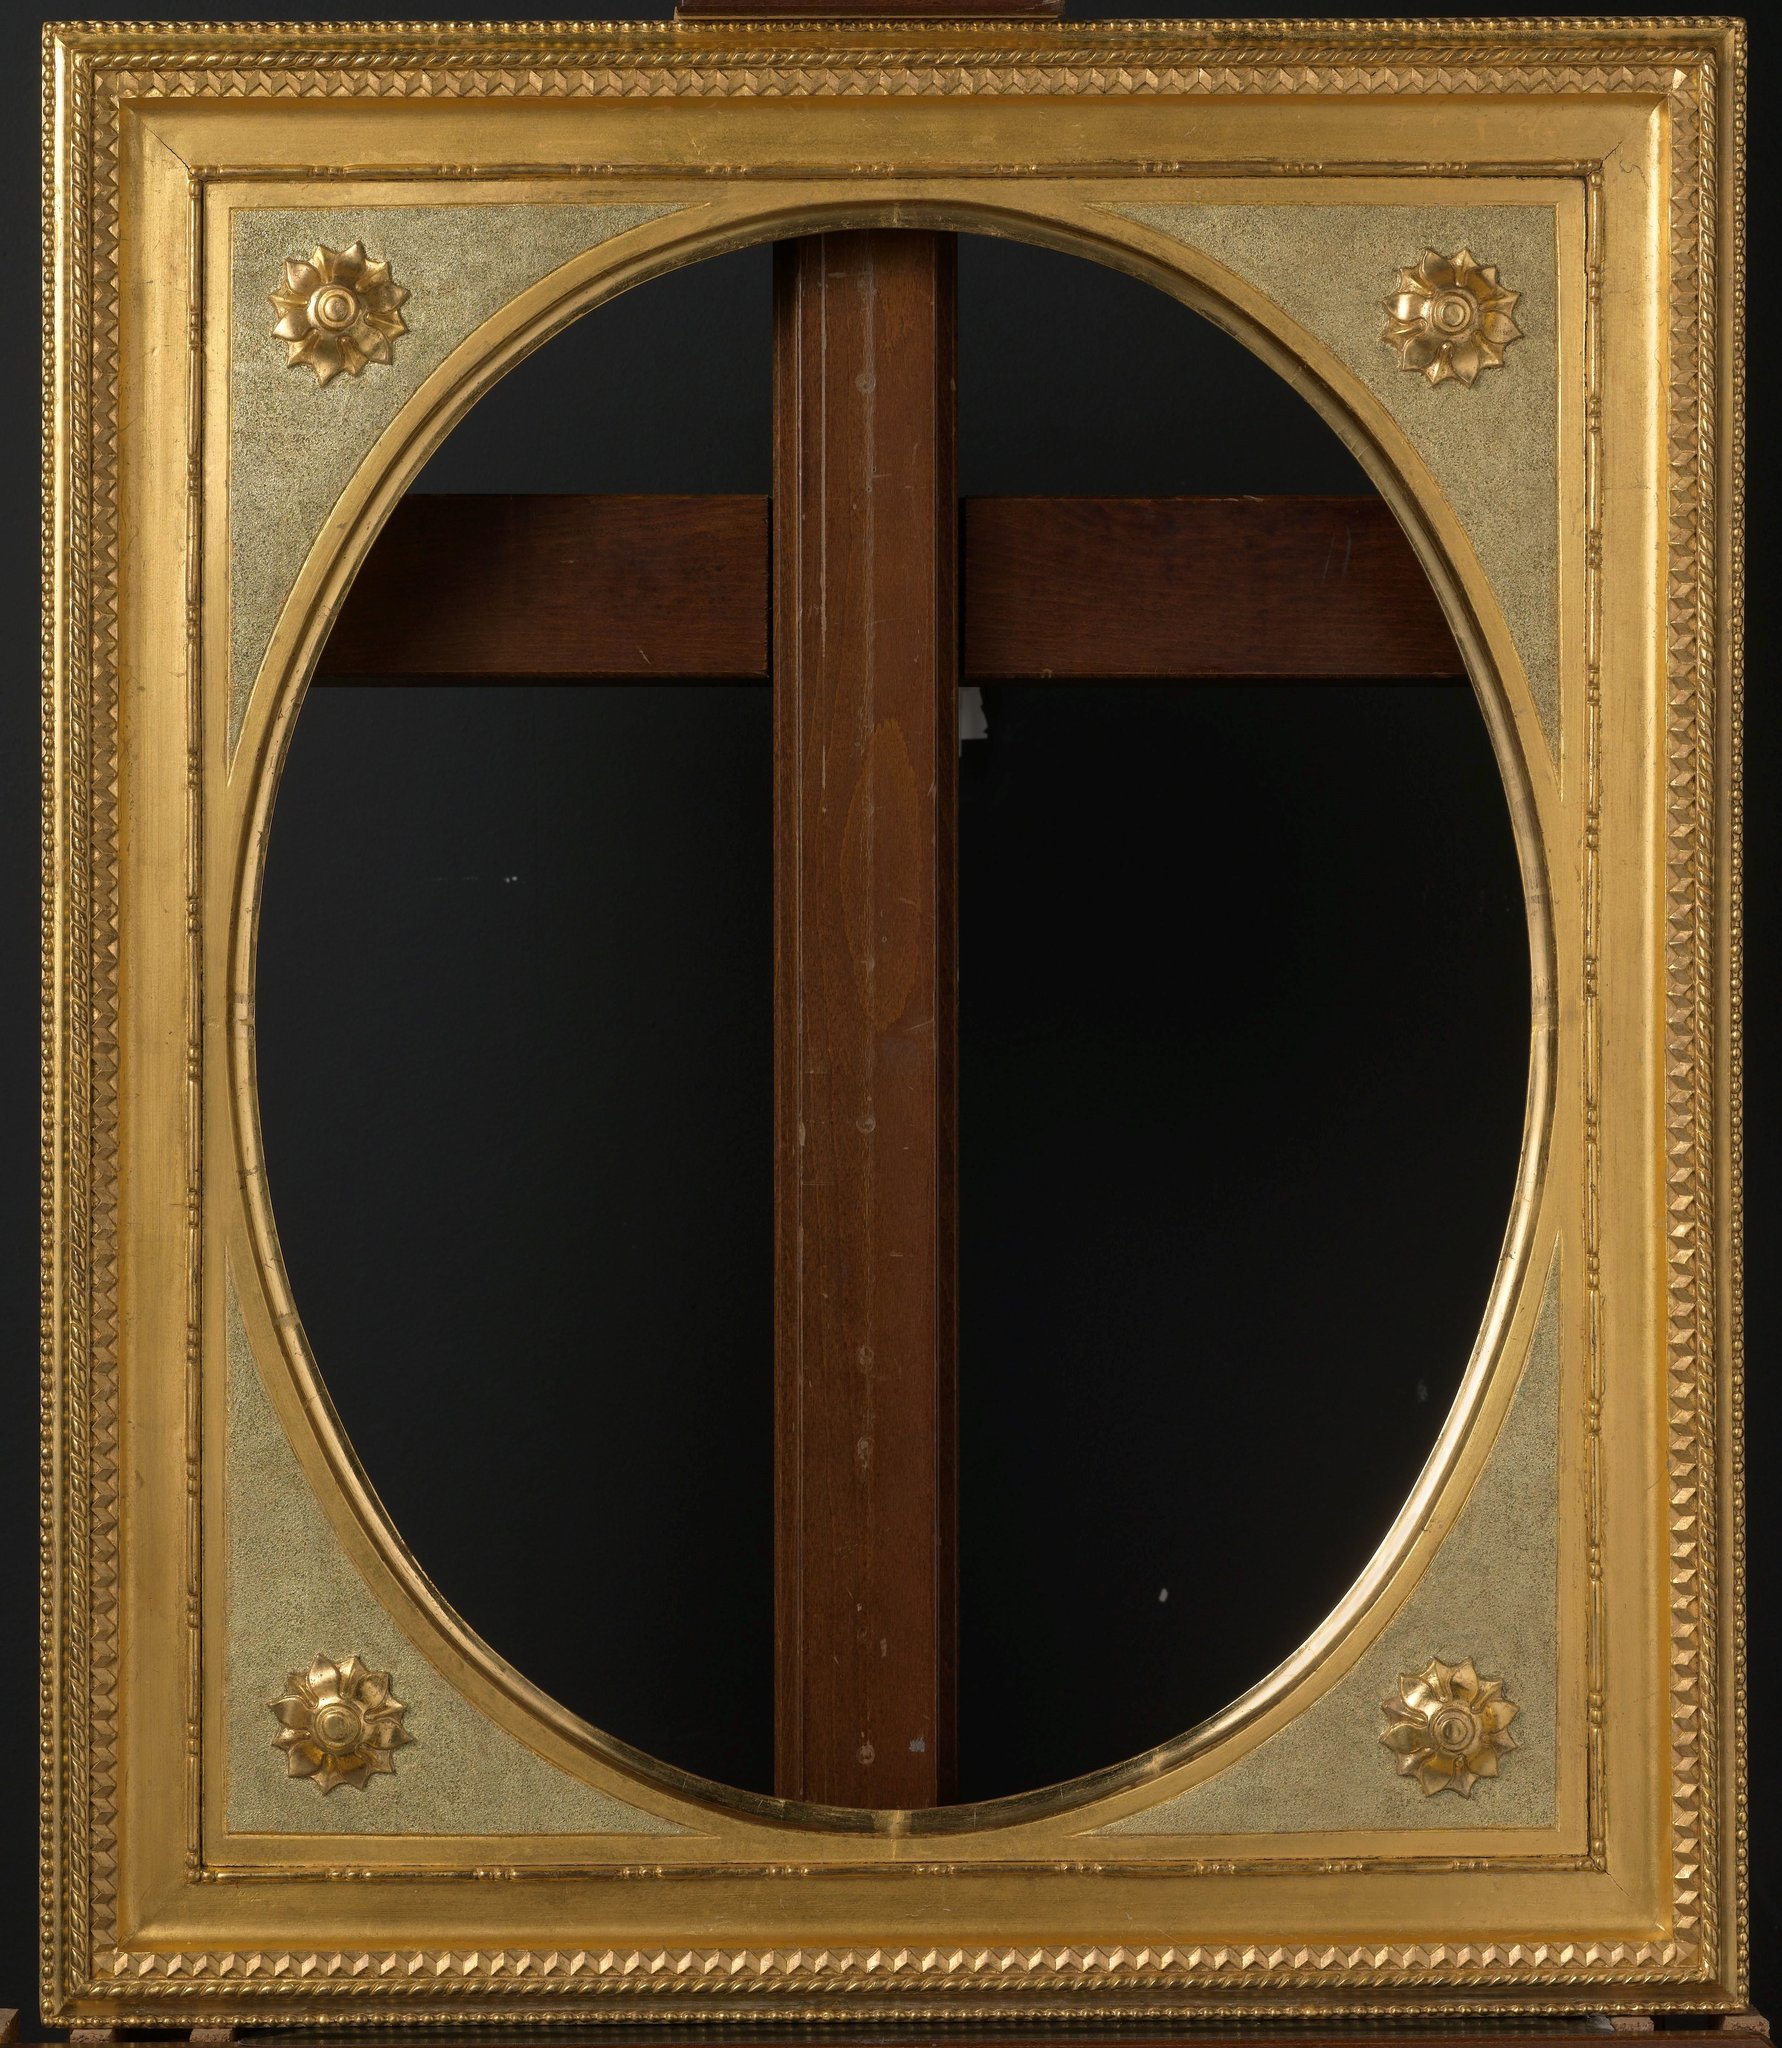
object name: frame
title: Schilderijlijst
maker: hendrik ebbens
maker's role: lijstenmaker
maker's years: 1726-1807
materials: wood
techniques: gilding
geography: the hague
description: Rechthoekig verguld kader waarin een ovaal is uitgespaard. De buitenrand versierd met een parelrand, daarbinnen een rand met touwmotief, daarbinnen een zigzagrand. In de hoeken een rozet.